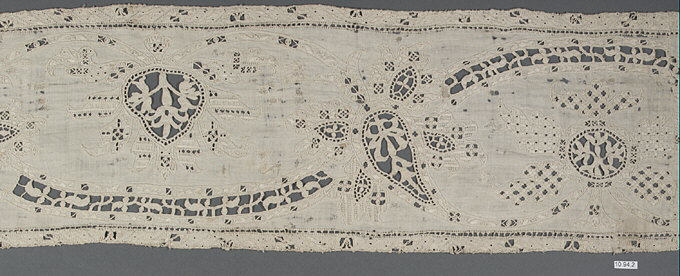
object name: fragment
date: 1567-1600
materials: linen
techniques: embroidery